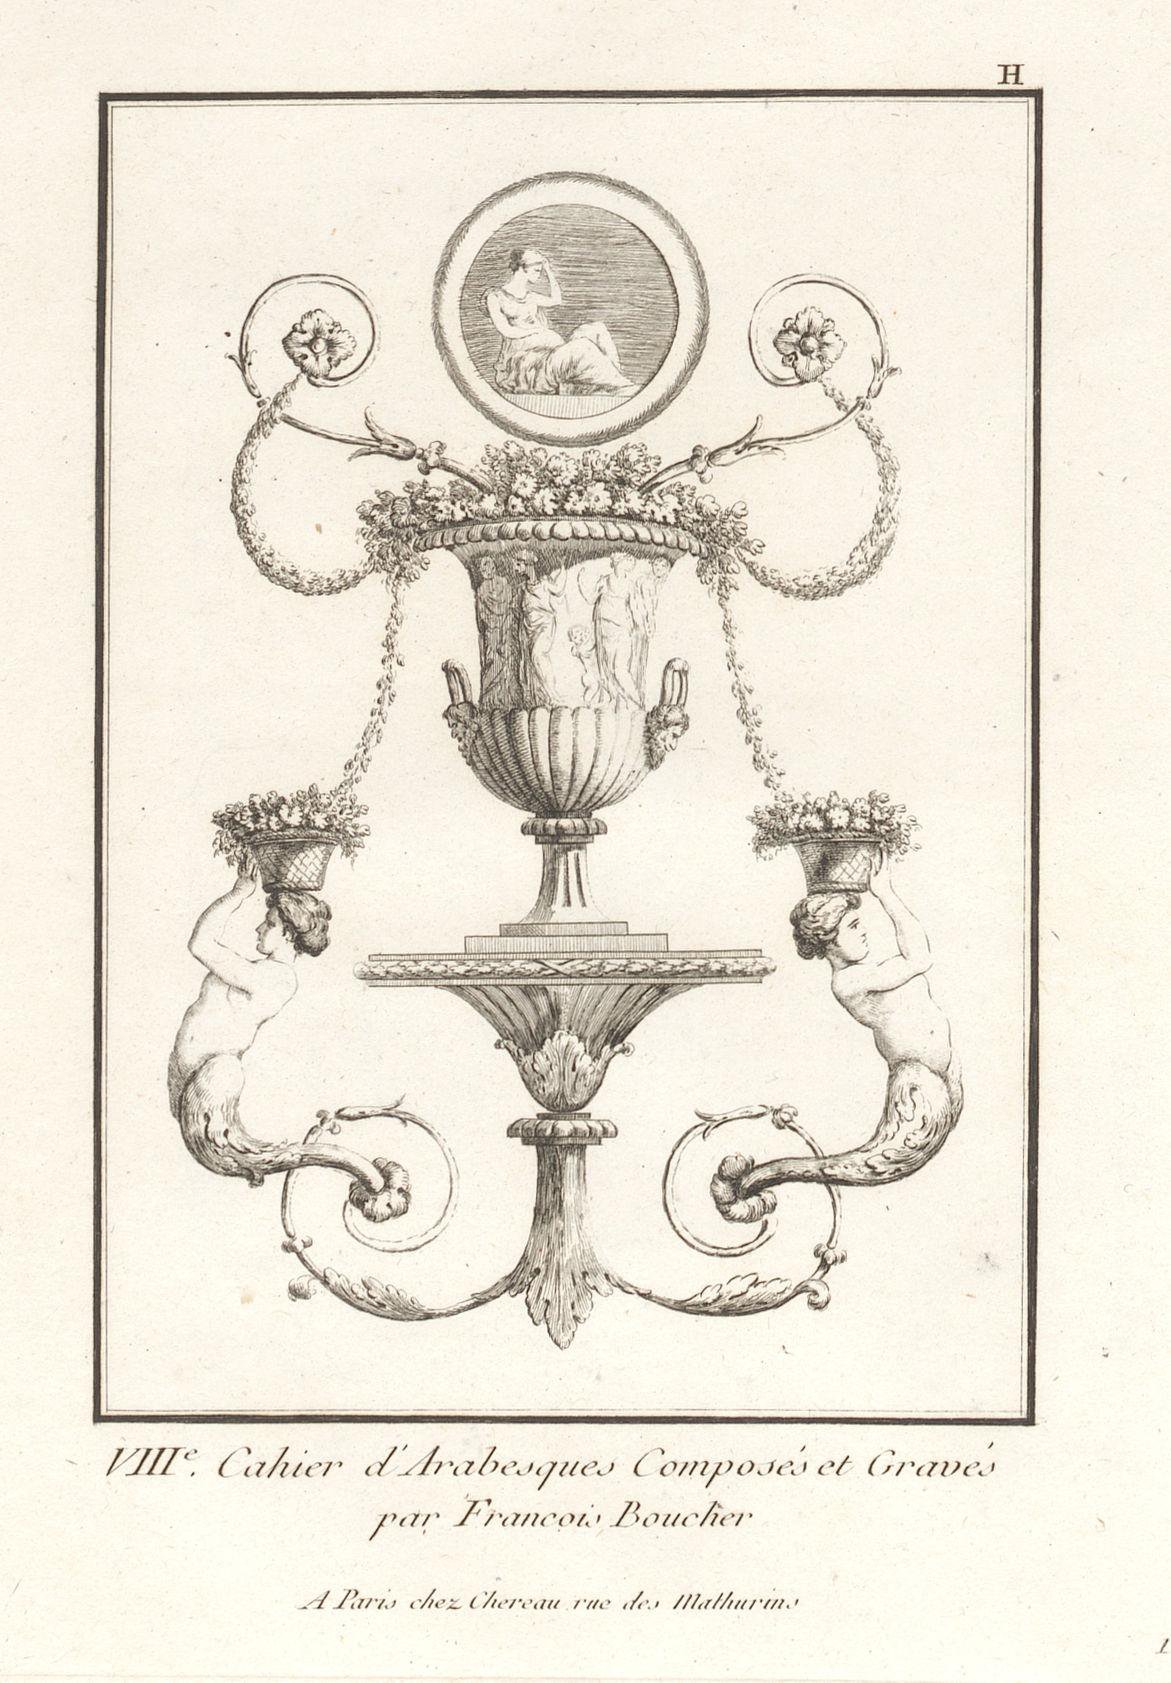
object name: titelprent, frontispice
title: Recueil d'arabesques, contenant les loges du Vatican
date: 1802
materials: paper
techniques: etching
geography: paris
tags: merman - aa - mermaid, siren, ornament ~ arabesque, vase ~ ornament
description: Doordat dit album bestaat uit meerdere, deels eerder uitgegeven prentreeksen, is de datering niet consequent. Het geheel is op de titelpagina gedateerd op 1802. Deze reeks is niet los gedateerd. De serietitel voor het gehele werk is "Recueil d'arabesques, contenant les loges du Vatican". De andere serietitel is de titel van de specifieke reeks binnen het geheel.